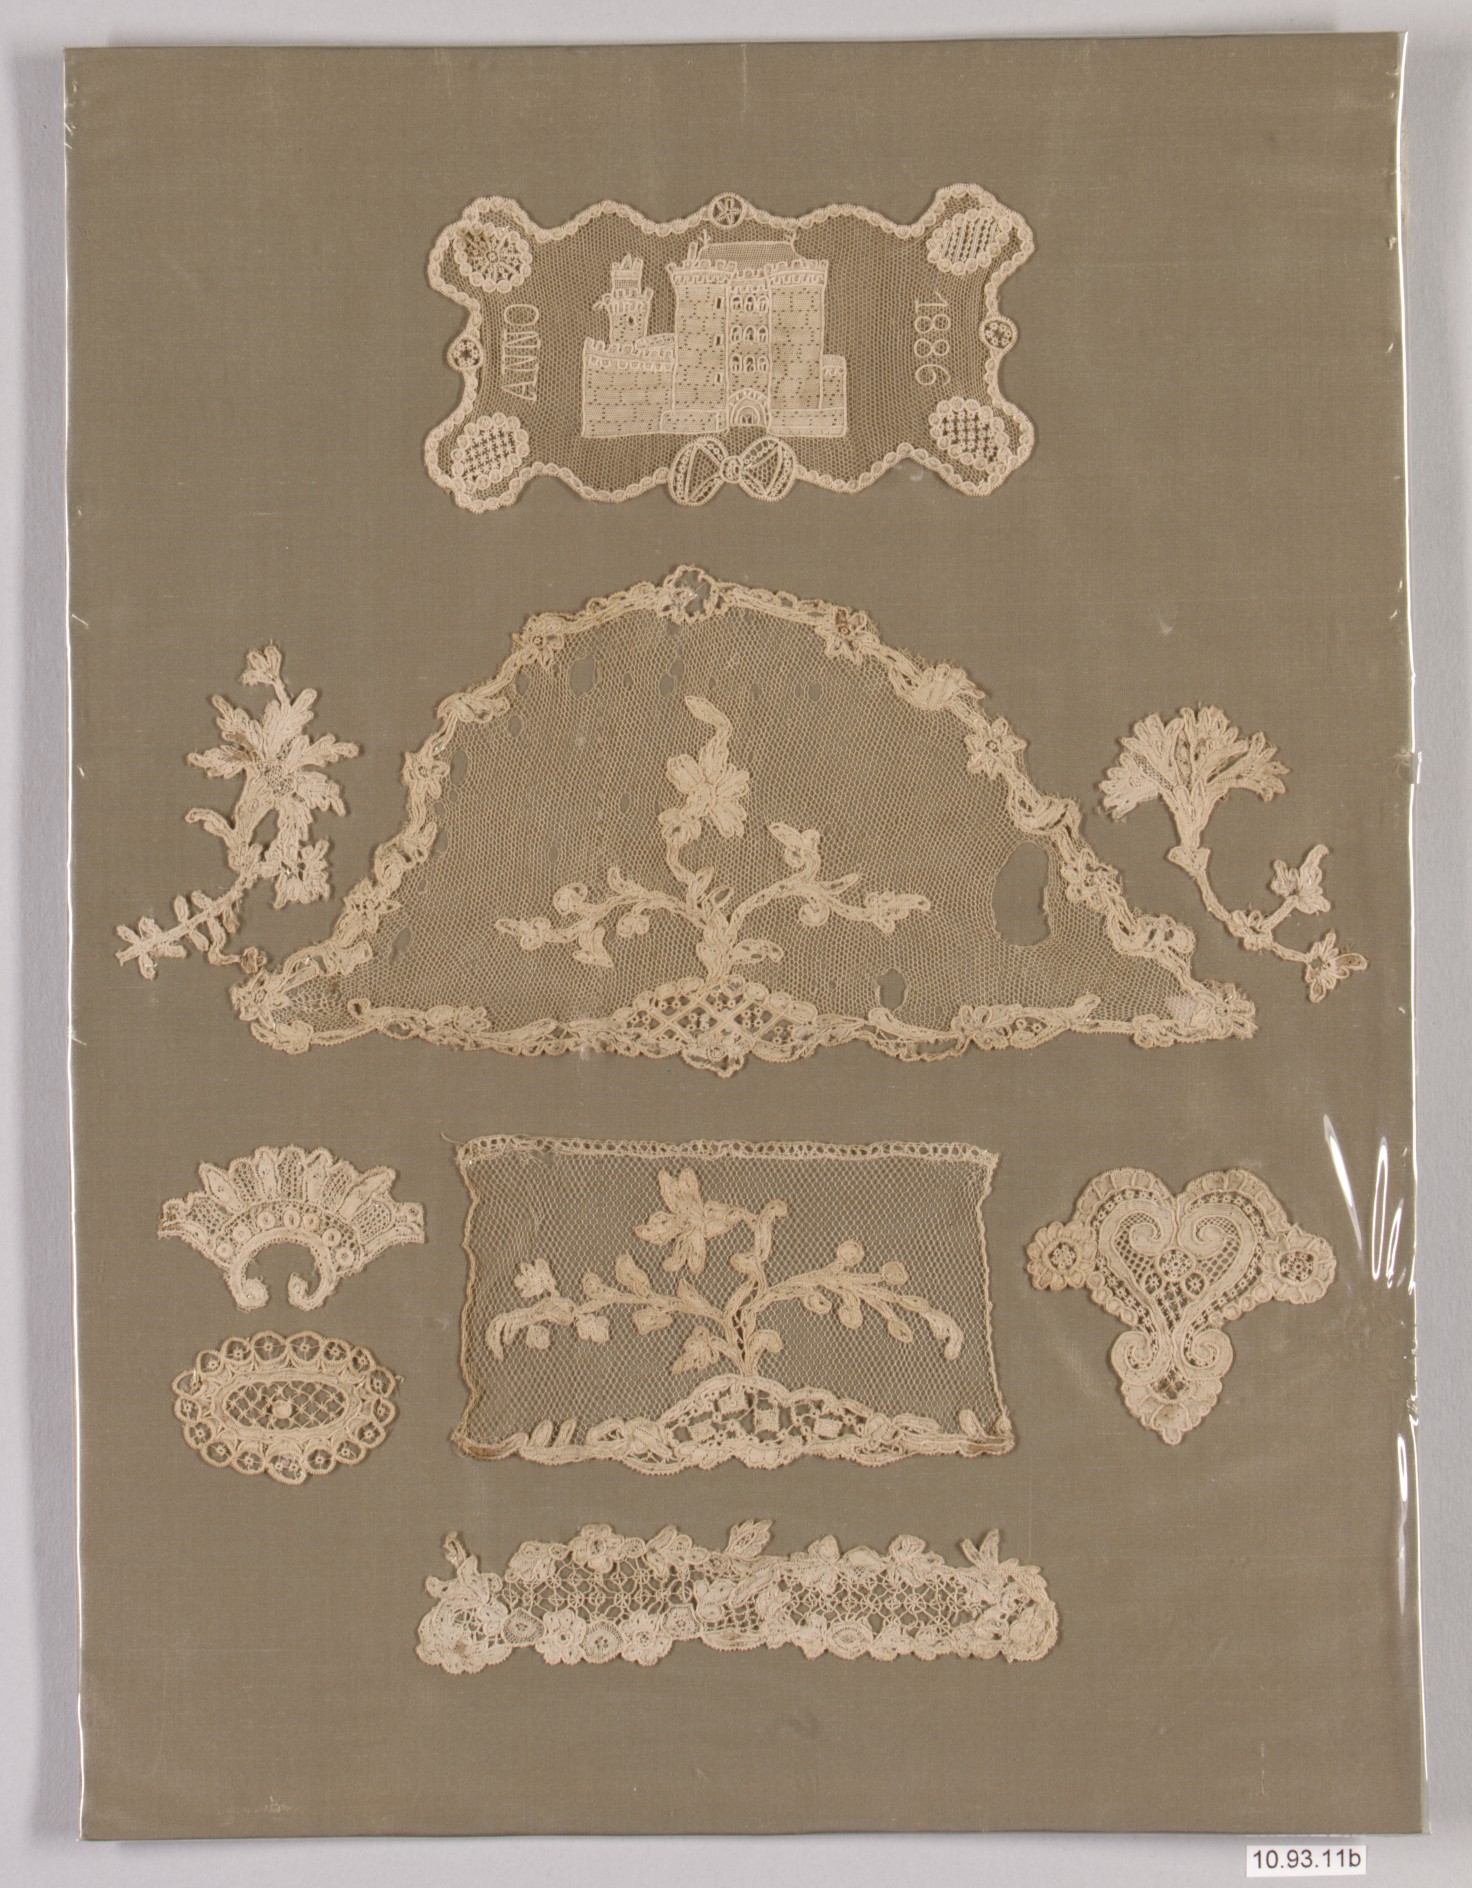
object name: sampler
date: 1801-1900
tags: buildings,flowers